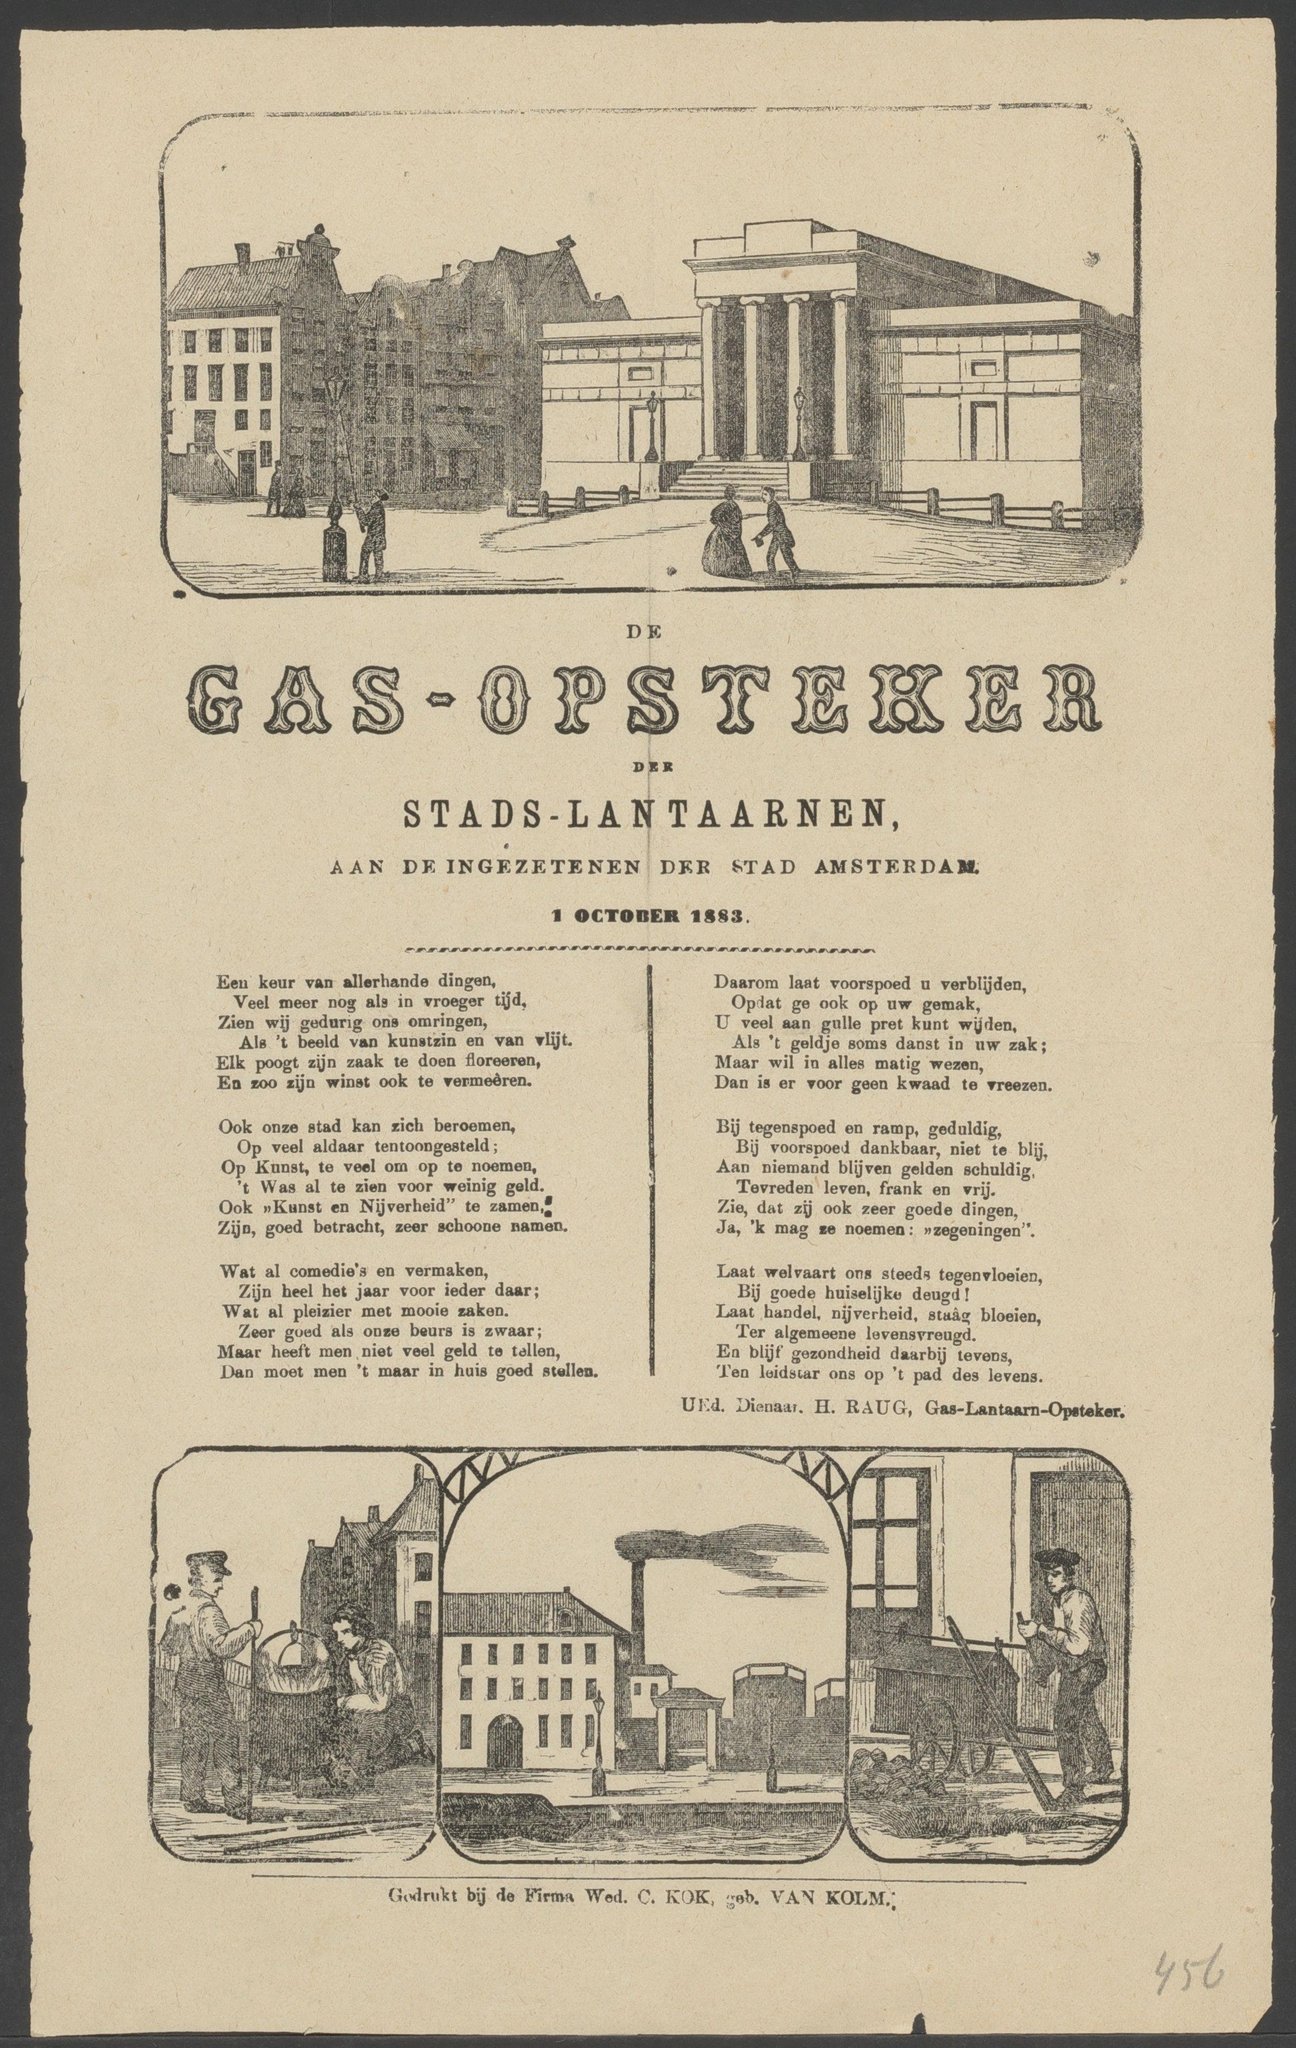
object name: print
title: Kermiswens van de gaslantaarnopstekers van Amsterdam voor het jaar 1883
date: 1883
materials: paper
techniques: letterpress printing, engraving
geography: amsterdam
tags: gas-lamp, gas supply, digging (industrial process), street lighting, amsterdam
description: Kermiswens van de Amsterdamse gaslantaarnopstekers voor het jaar 1883. Centraal een vers in twee kolommen. Bovenaan de Dam met de beurs van Zocher te Amsterdam. Onderaan de Hollandsche Gasfabriek en twee gasfitters aan het werk. Van de gaslantaarnopsteker: H. Raug. Onderwerpsrubrieken binnen de Atlas Zeden en Gewoonten: Zeden en gewoonten in engeren zin, Volksleven, Volksbladen, Nieuwjaars- en Kerstwenschen, Amsterdam.